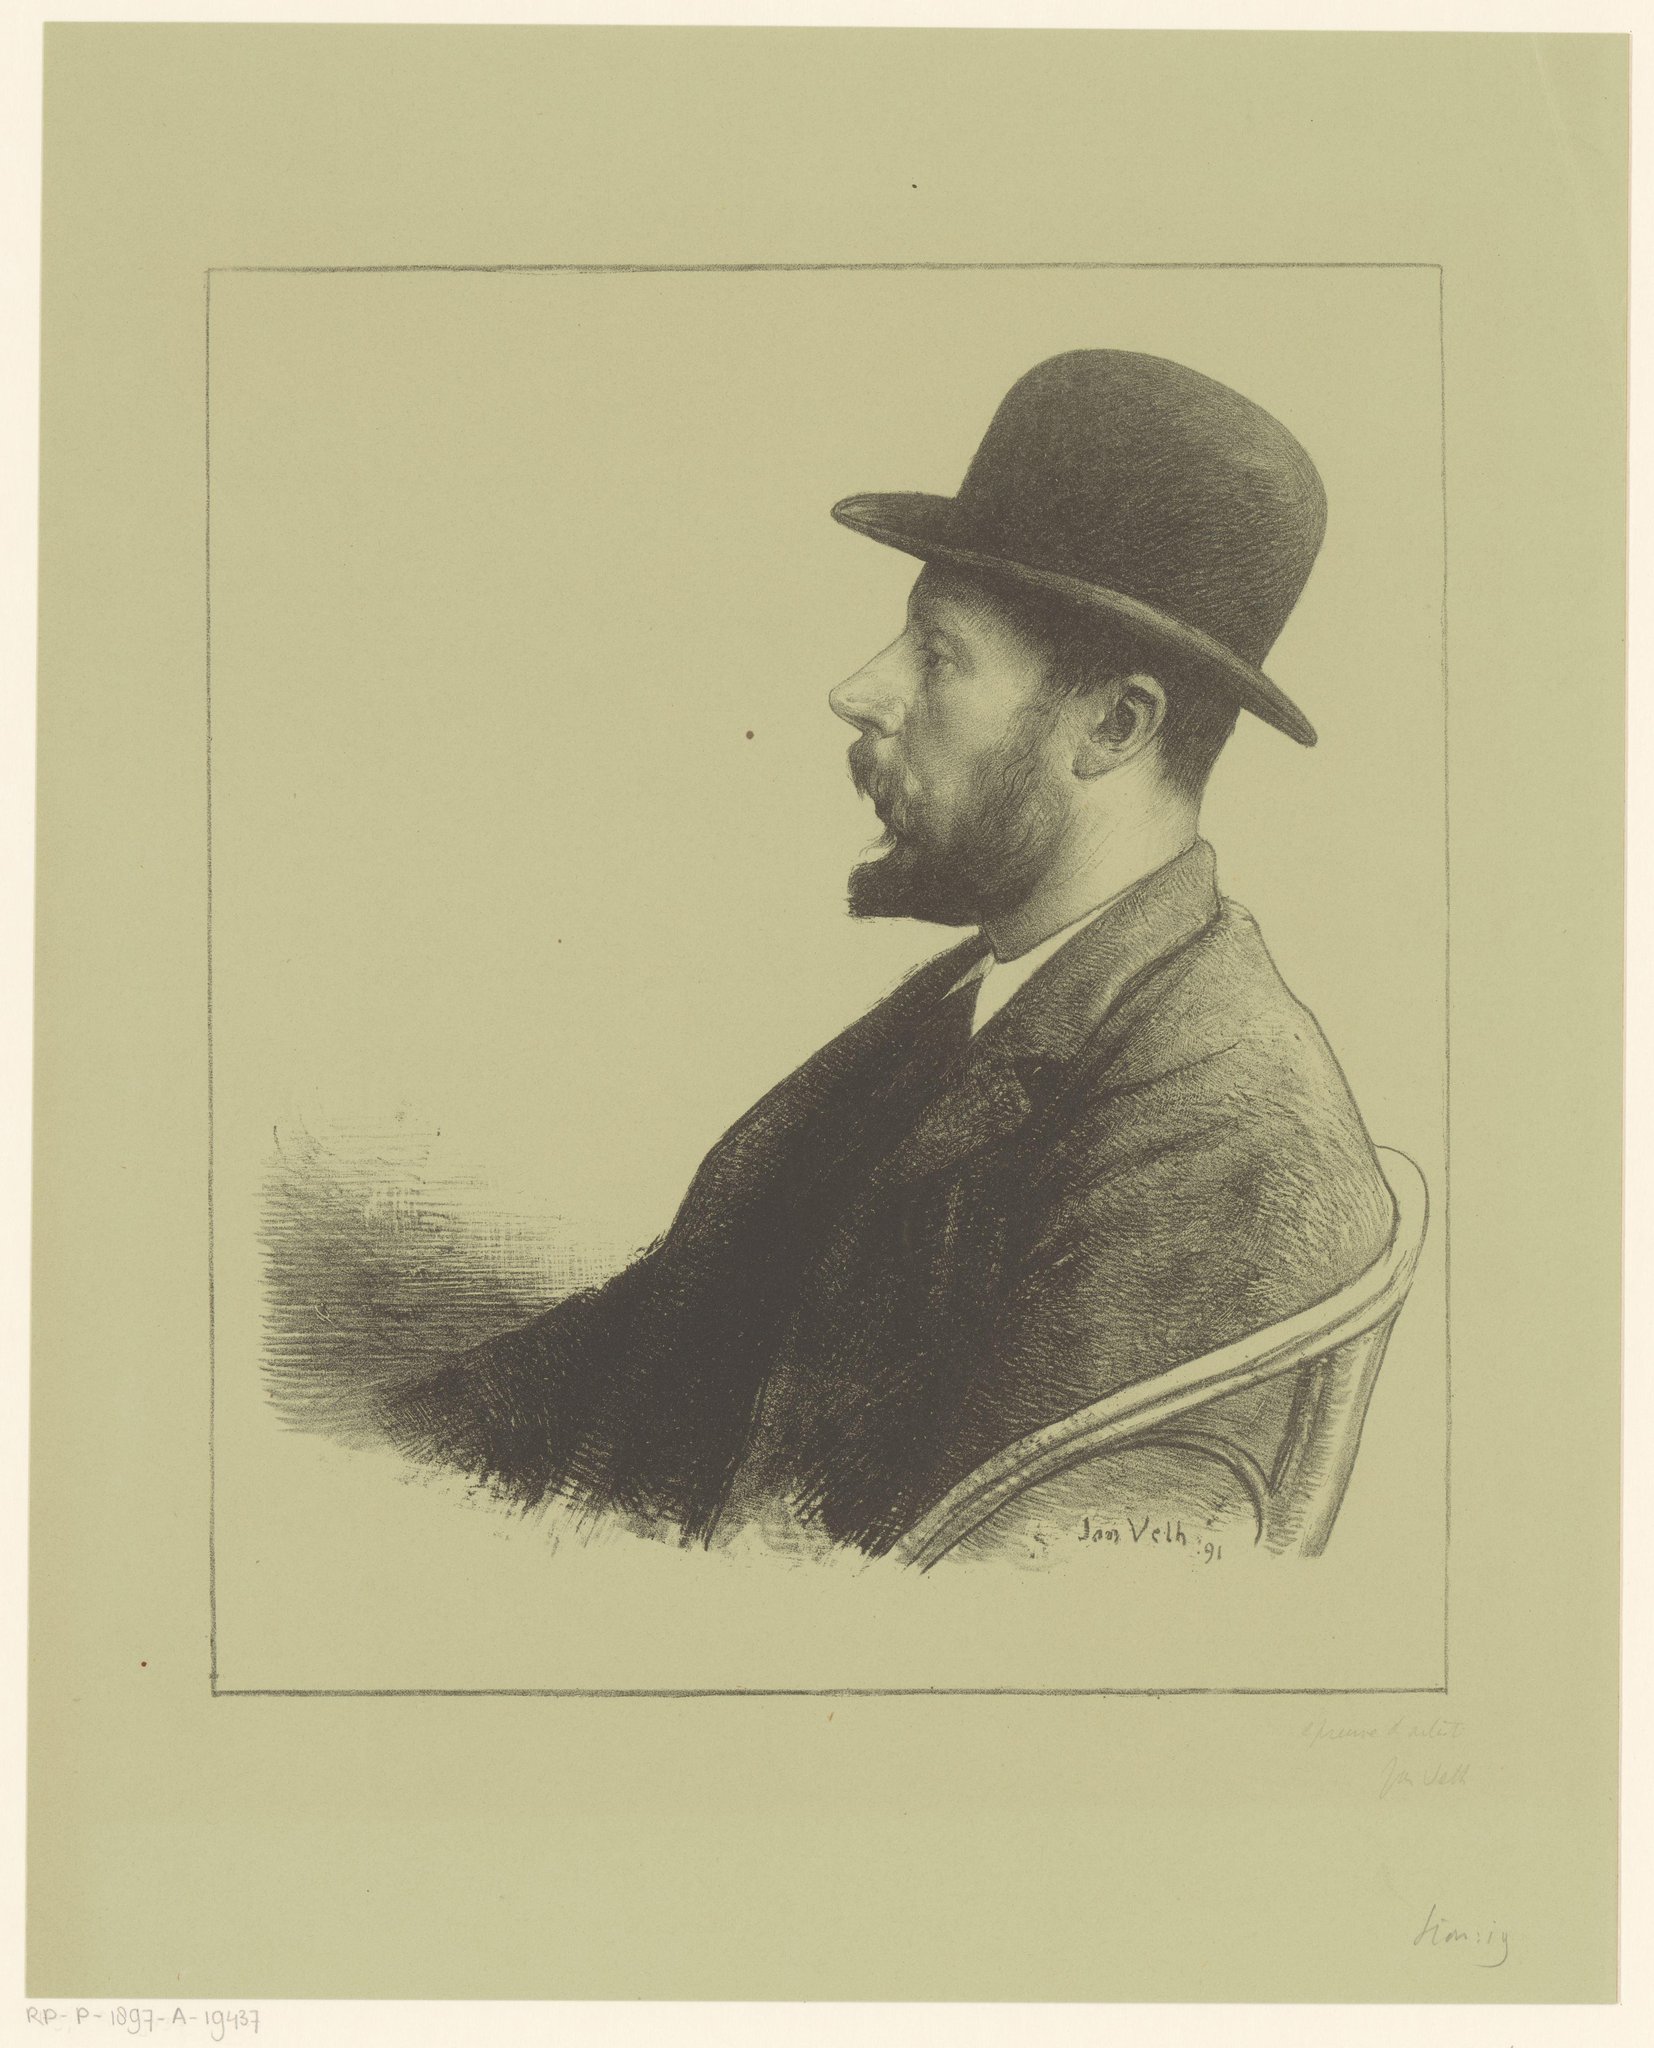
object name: print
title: Bekende tijdgenooten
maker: jan veth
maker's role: designer, draughtsman, painter, print maker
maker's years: 1864-1925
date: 1891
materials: paper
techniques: lithograph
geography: netherlands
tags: rotterdam, amsterdam, painter, print maker, george hendrik breitner, historical persons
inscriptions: collector's mark: Lugt 2228, inscription: ‘epreuve d'artiste / Jan Veth’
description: Deze prent werd uitgegeven als bijvoegsel van De Amsterdammer op 116 augustus 1891.